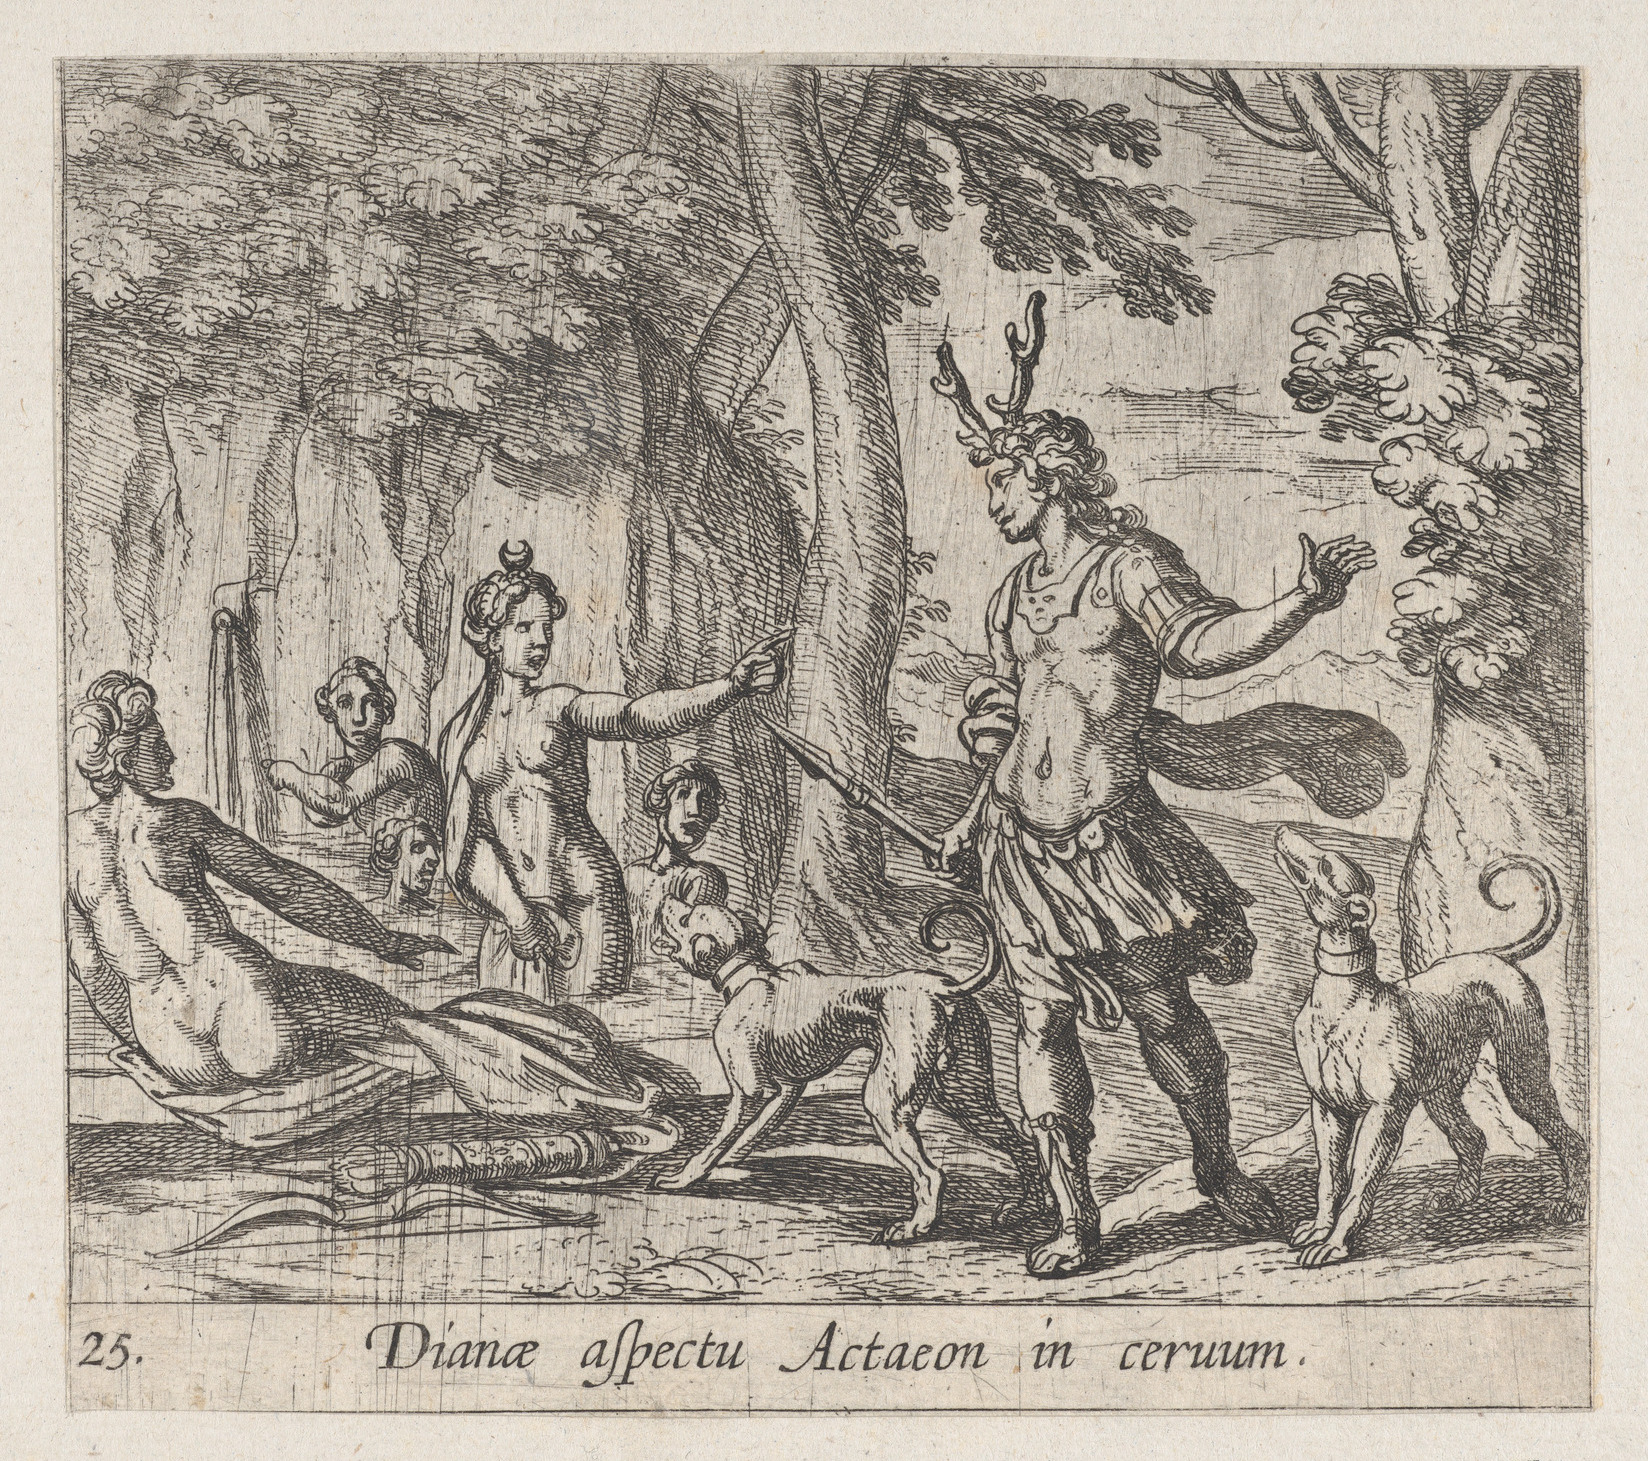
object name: print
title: Plate 25: Acteon Changed into a Stag (Dianae aspectu Actaeon in ceruum), from Ovid's 'Metamorphoses'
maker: antonio tempesta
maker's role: artist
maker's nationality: italian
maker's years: 1555-1630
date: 1606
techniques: etching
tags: men,female nudes,dogs